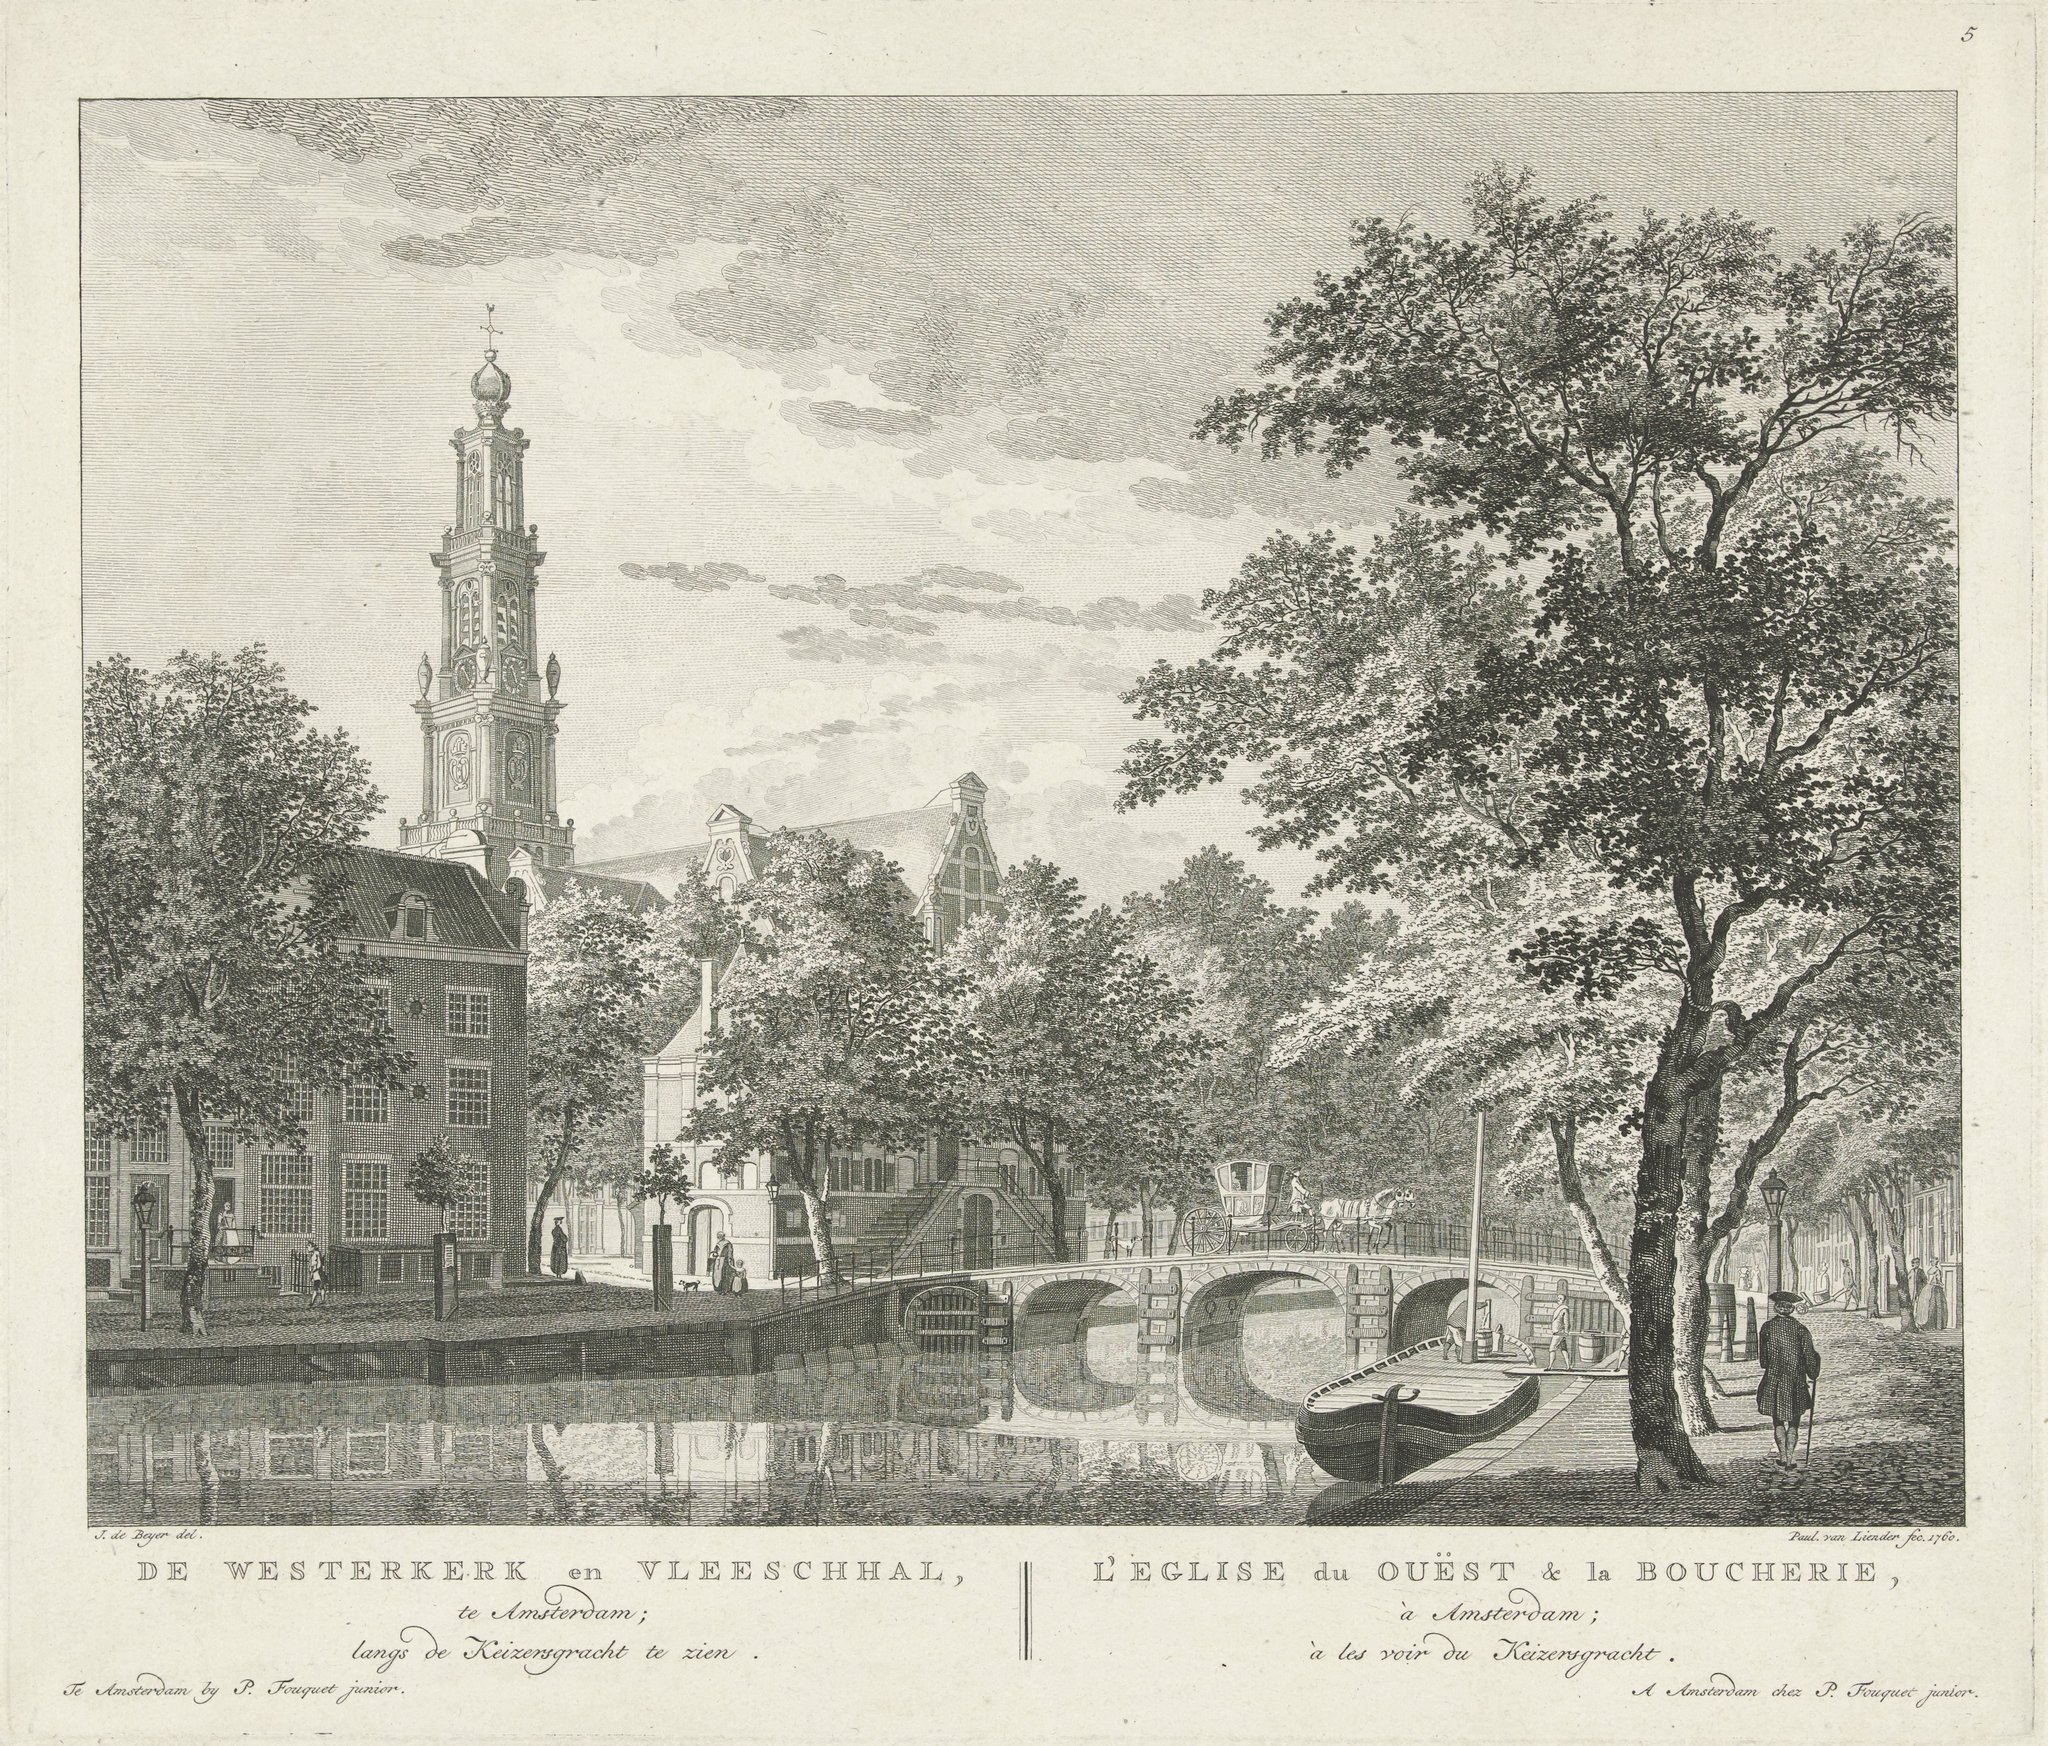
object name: print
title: De Westerkerk en Vleeschhal, te Amsterdam; langs de Keizersgracht te zien / L'Eglise du Ouëst & la Boucherie, à Amsterdam; à les voir du Keizersgracht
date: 1760-1783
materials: paper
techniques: engraving, etching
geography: amsterdam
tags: bridge in city across river, canal, etc. (+ city(-scape) with figures, staffage), church (exterior), canals, waters (in city), weigh-house, market-hall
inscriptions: collector's mark: Lugt 2166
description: Deze prent is ook gebruikt in de zogenaamde Atlas van Fouquet.* Pierre Fouquet gaf vanaf 1760 stadsgezichten van Amsterdam - naar tekeningen van verschillende kunstenaars, gemaakt door verschillende prentmakers - uit. Deze prenten werden aanvankelijk los of in series verkocht. Zoals toen gebruikelijk kon de koper de prenten zelf laten inbinden. Hiertoe gaf Fouquet tussen 1778 en 1783 een titelblad, plattegrond en inhoudsopgave van de tot dusver 100 uitgegeven prenten uit (1). Gezien de inhoud afhankelijk was van wat de koper had verzameld verschilt de inhoud van de verschillende bewaarde Fouquetatlassen onder deze titel sterk. Ook zijn er exemplaren bekend waar tevens andere prenten aan zijn toegevoegd. Omdat er behoefte bleek aan uitleg bij de platen werd in 1783 een nieuwe versie van de atlas uitgegeven, aangevuld met tekst en twee prenten. De aangegeven volgorde veranderde maar de platen van de al eerder uitgegeven prenten bleven ongewijzigd. Deze uitgave werd in opdracht van Fouquet gedrukt bij Daniël Jean Changuion en Petrus den Hengst (2). Een tiental platen werd bijgewerkt en verscheen, met nieuw impressum, in het vervolg van Wagenaars geschiedenis van Amsterdam, uitgeven door Petrus Conradi en Folkert van der Plaats (3). Een aantal jaar na het overlijden van Fouquet kwam Evert Maaskamp met een nieuwe uitgave van de atlas, met verbeterde tekst en toevoeging van twee prenten. Op alle platen verwijderde hij het oude en liet hij zijn eigen impressum zetten (4). De huidige staat van de prent komt voor in exemplaren van de onder (1) en (2) genoemde werken. * Onder de Atlas van Fouquet of Fouquetatlas verstaan we de hieronder vermelde publicaties (1), (2) en (4). (1). Afbeeldingen van de wyd-vermaarde koopstad Amsterdam benevens des zelvs voornaamste gebouwen en gezigten alle naar het leeven getekend / Receuil des edifices les plus considerables et des plus belles vues, de la fameuse ville d'Amsterdam, dessinées d'après nature. Amsterdam: Pierre Fouquet, 1778-1783. (2). Nieuwe atlas, van de voornaamste gebouwen en gezigten der stad Amsterdam, met derzelver beknopte beschryvingen. 2 delen. Amsterdam: Daniël Jean Changuion en Petrus den Hengst [in opdracht van Pierre Fouquet], 1783. (3). Stijl, Simon. Amsterdam, in zyne geschiedenissen, voorregten, koophandel, gebouwen, kerkenstaat, schoolen, schutterye, gilden en regeeringe, beschreeven. Om te dienen ten vervolge op het werk van Jan Wagenaar (…). 10 delen. Amsterdam en Harlingen: Petrus Conradi en Folkert van der Plaats, 1788-1801. (4). Nieuwe atlas, van de voornaamste gebouwen en gezigten der stad Amsterdam. Met derzelver beknopte beschryvingen. Amsterdam: Evert Maaskamp, 1805. * Het aantal vermelde staten is gebaseerd op het aantal gevonden staten. Mogelijk zijn er meer staten van deze prent.